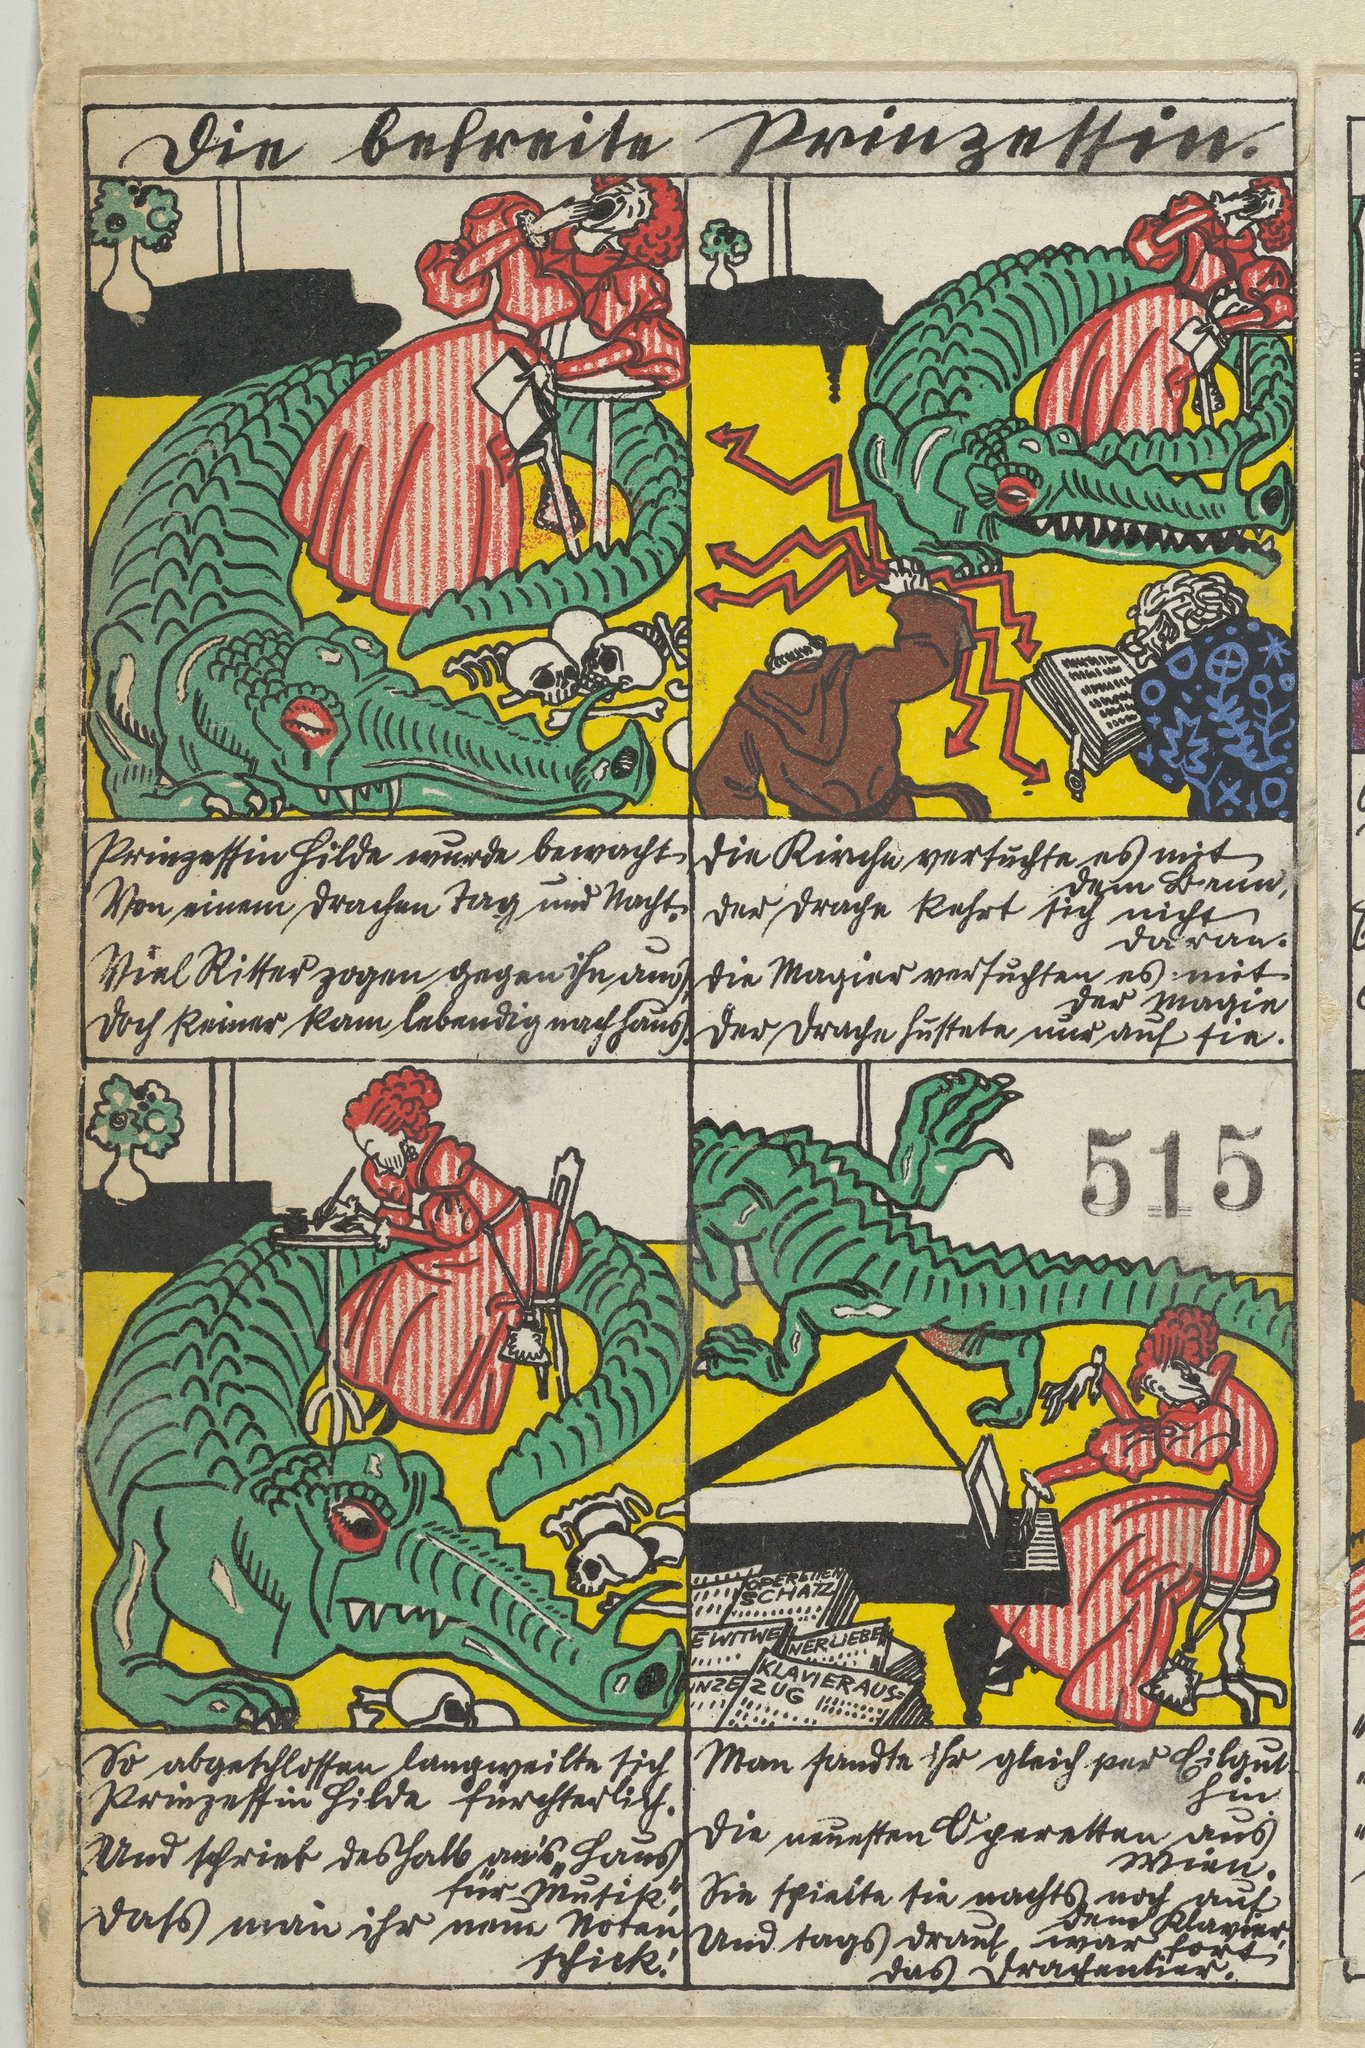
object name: print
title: The Rescued Princess (Die befreite Prinzessin)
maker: moriz jung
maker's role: artist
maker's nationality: austrian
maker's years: 1885-1915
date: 1911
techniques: lithograph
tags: women,crocodiles